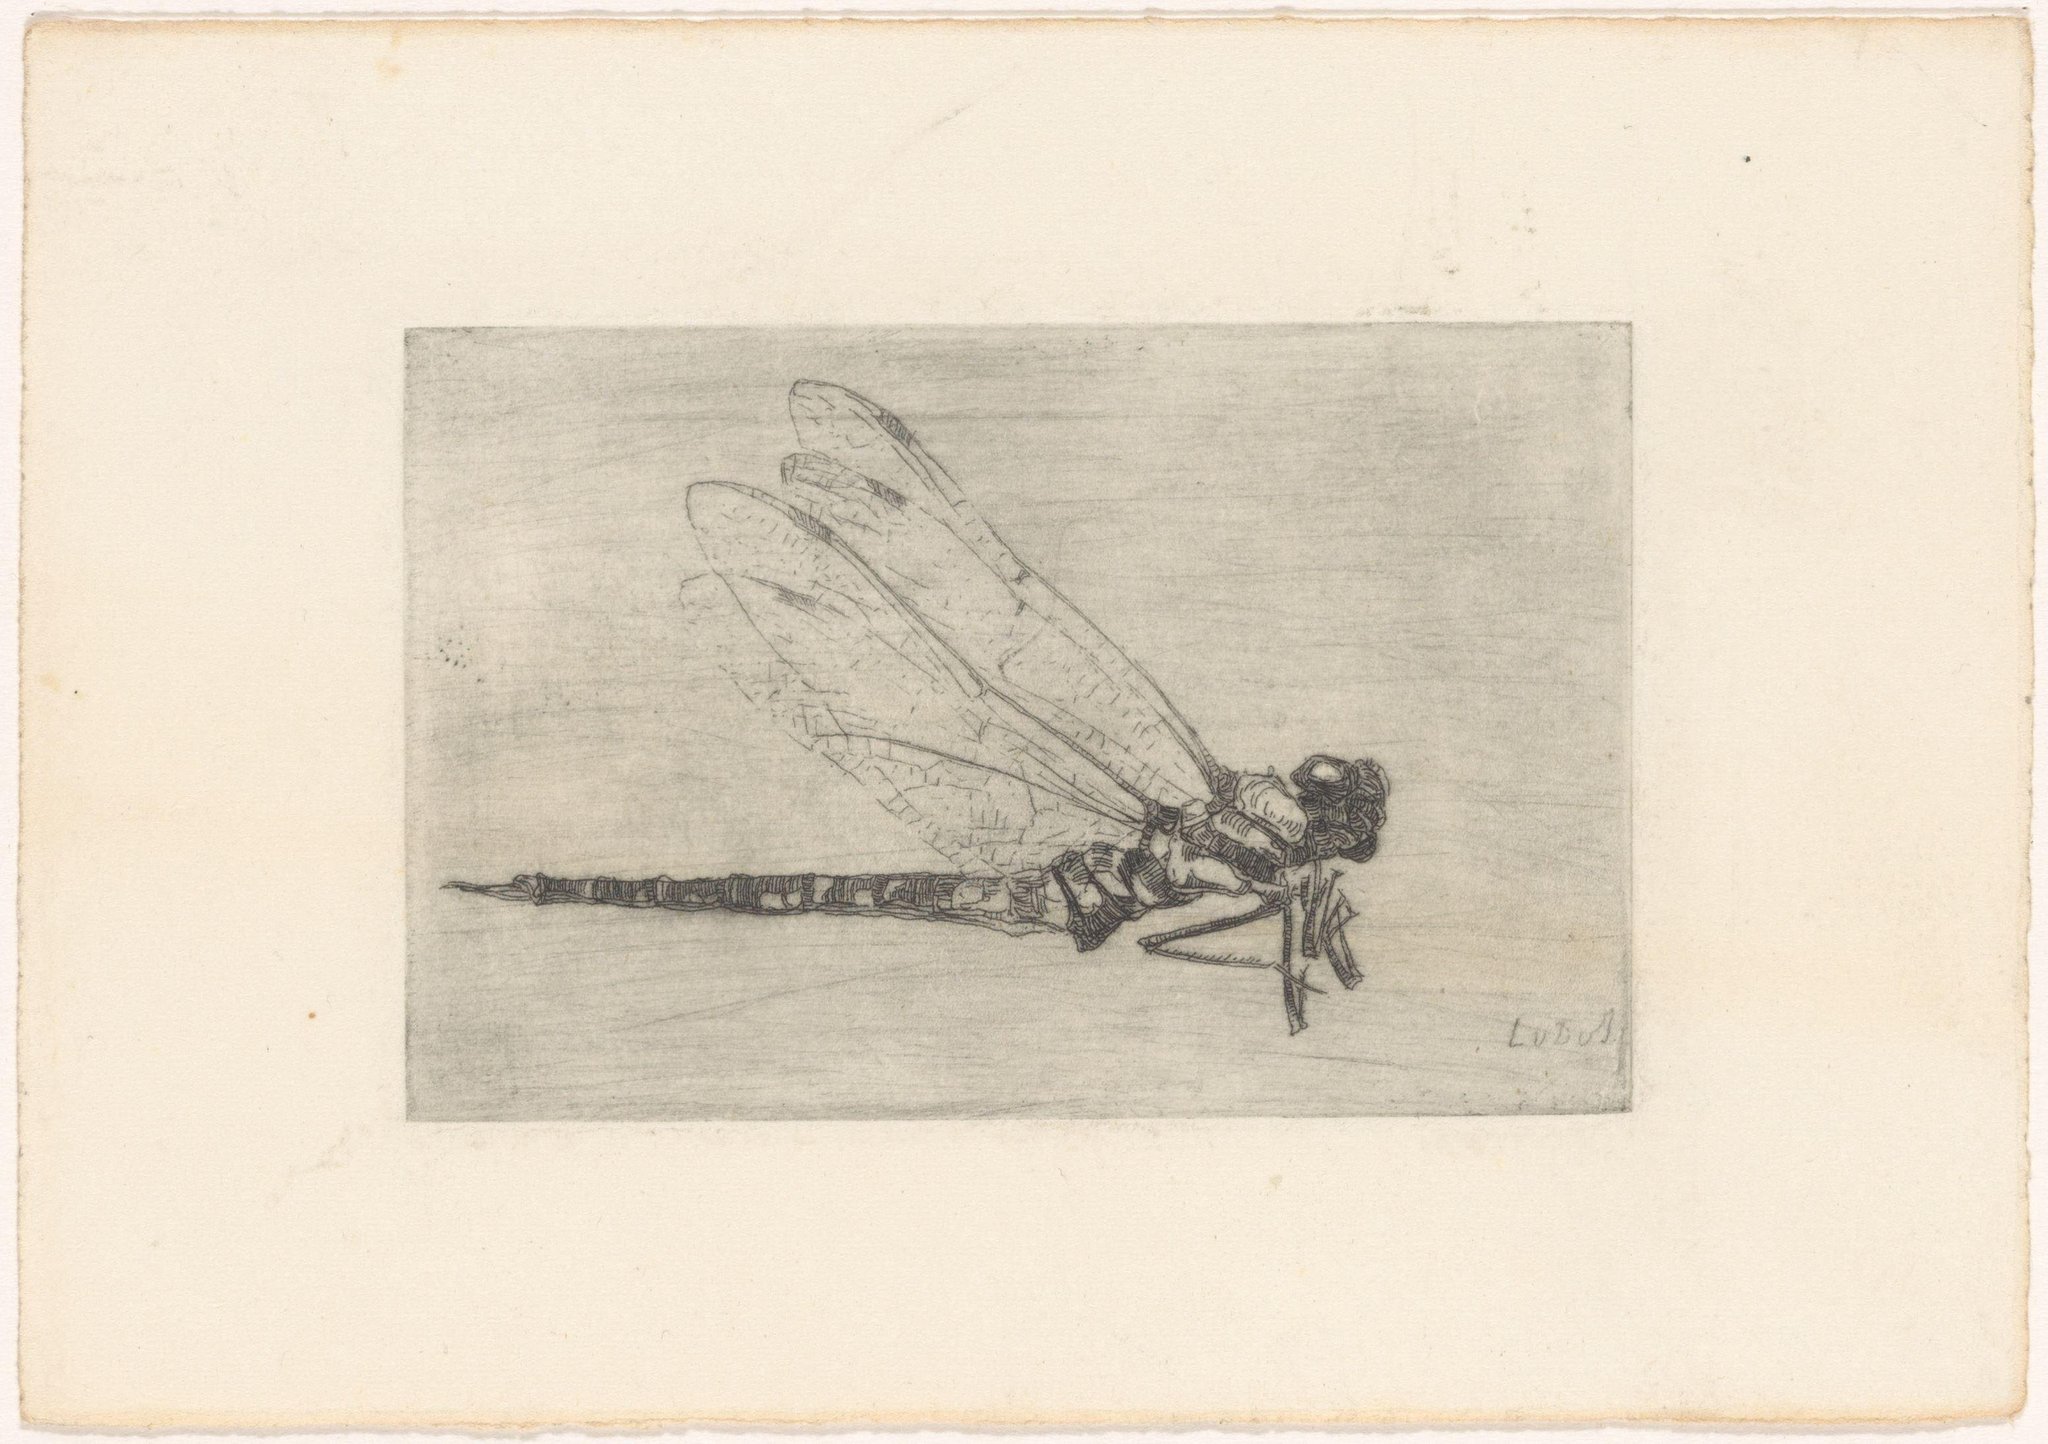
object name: print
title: Libel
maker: lucie van dam van isselt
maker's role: draughtsman, print maker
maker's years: 1871-1949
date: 1881-1949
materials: paper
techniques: etching, intaglio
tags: insects: dragon-fly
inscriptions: collector's mark: Lugt 2228